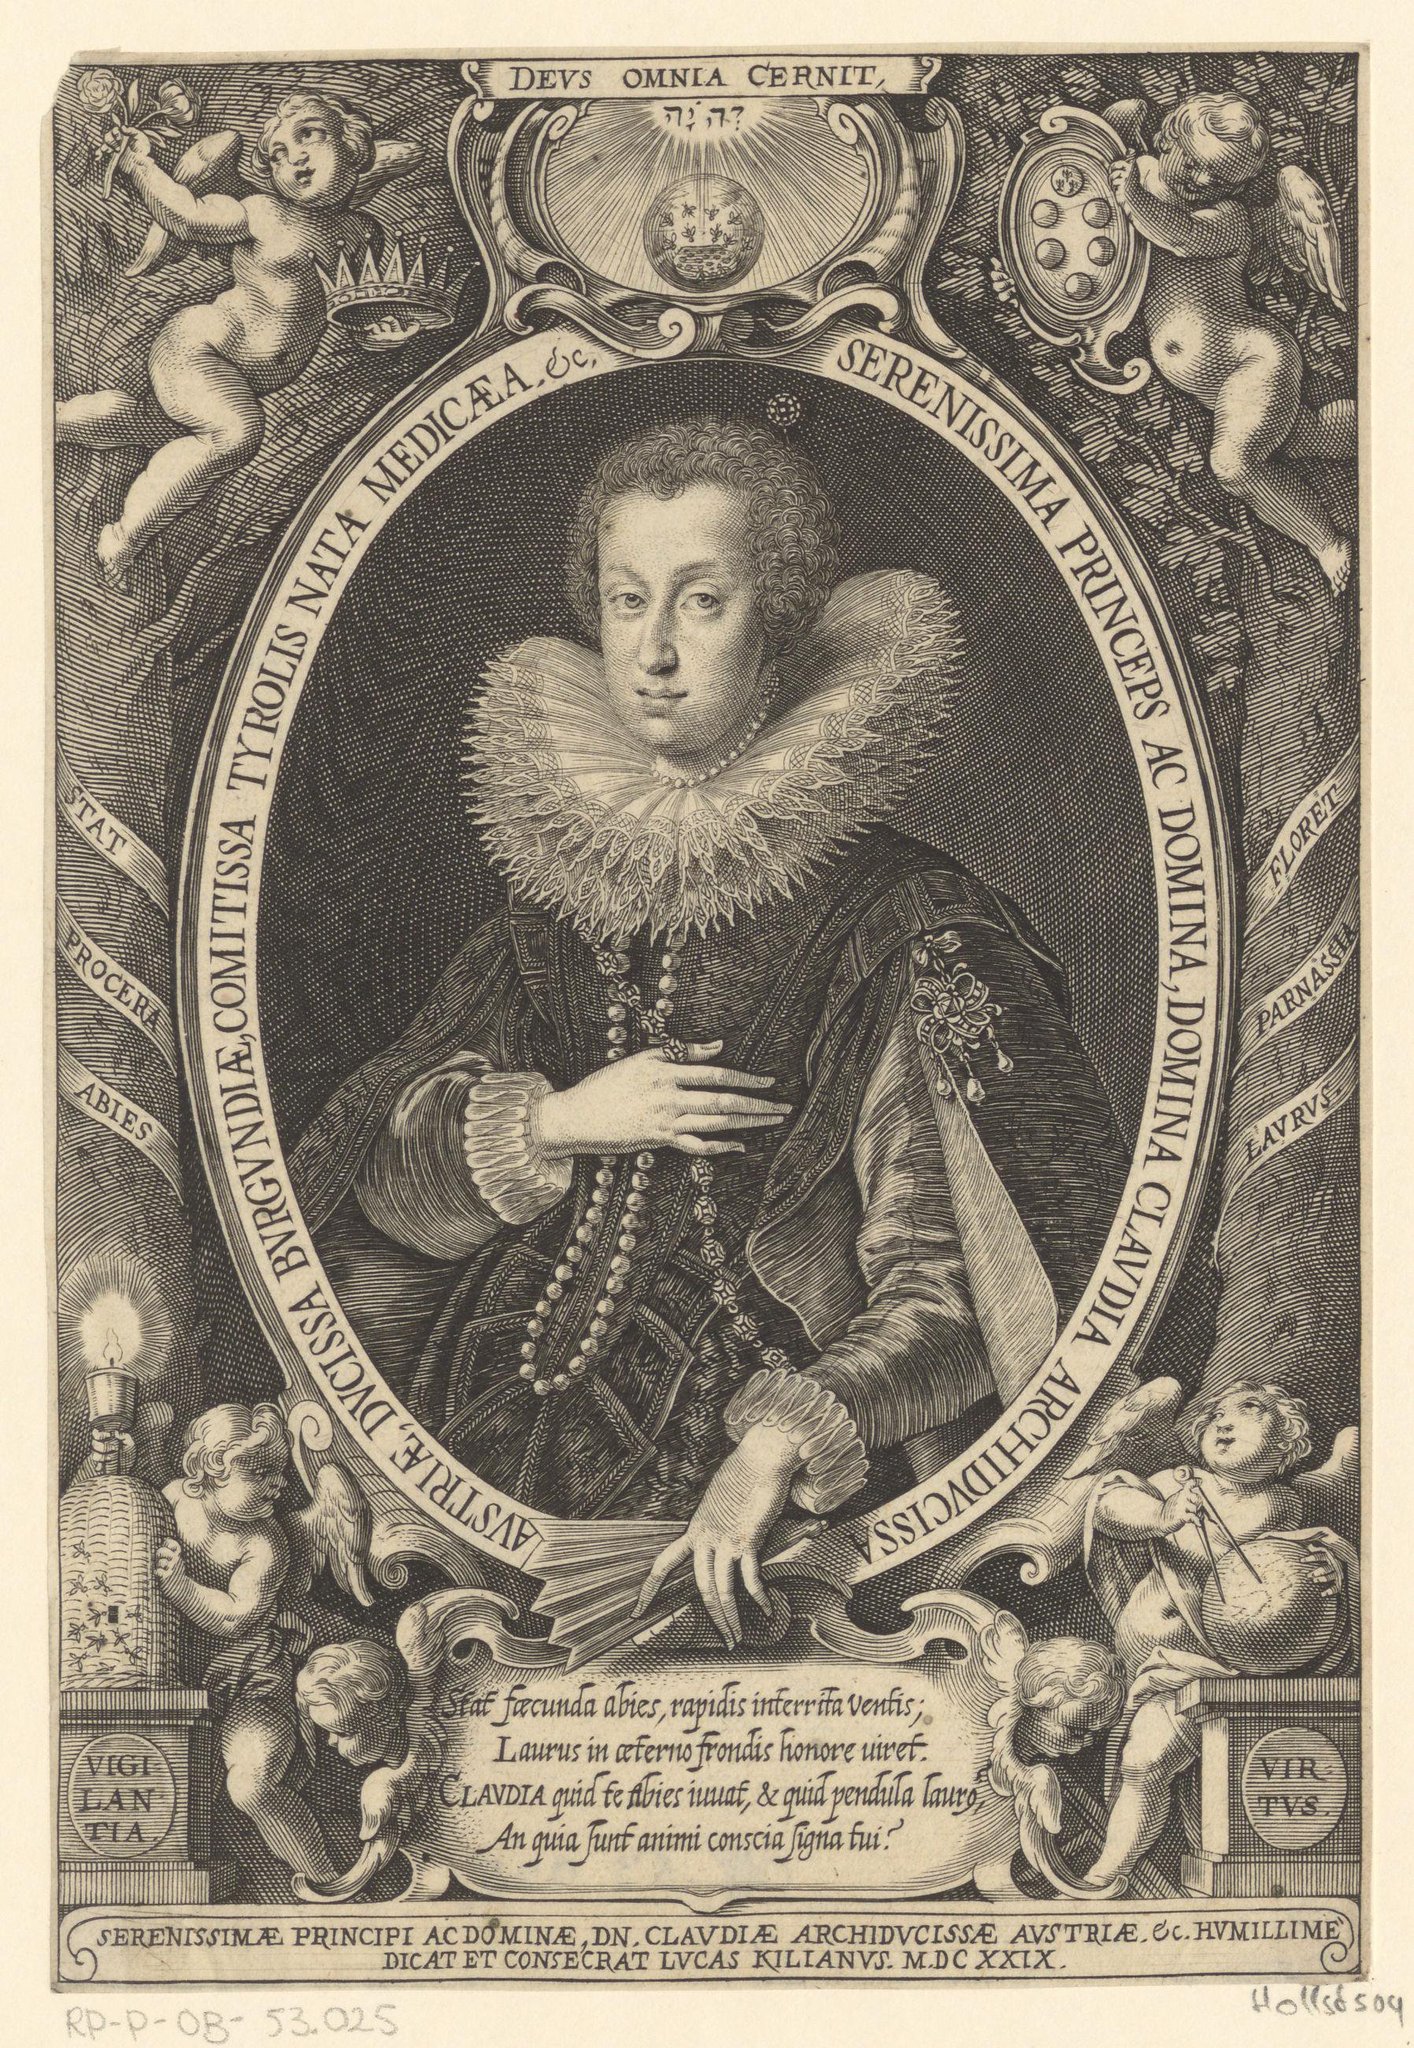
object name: print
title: Portret van Claudia de' Medici, aartshertogin van Oostenrijk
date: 1629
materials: paper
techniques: engraving, etching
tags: claudia de' medici (aartshertogin van oostenrijk), historical persons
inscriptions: date